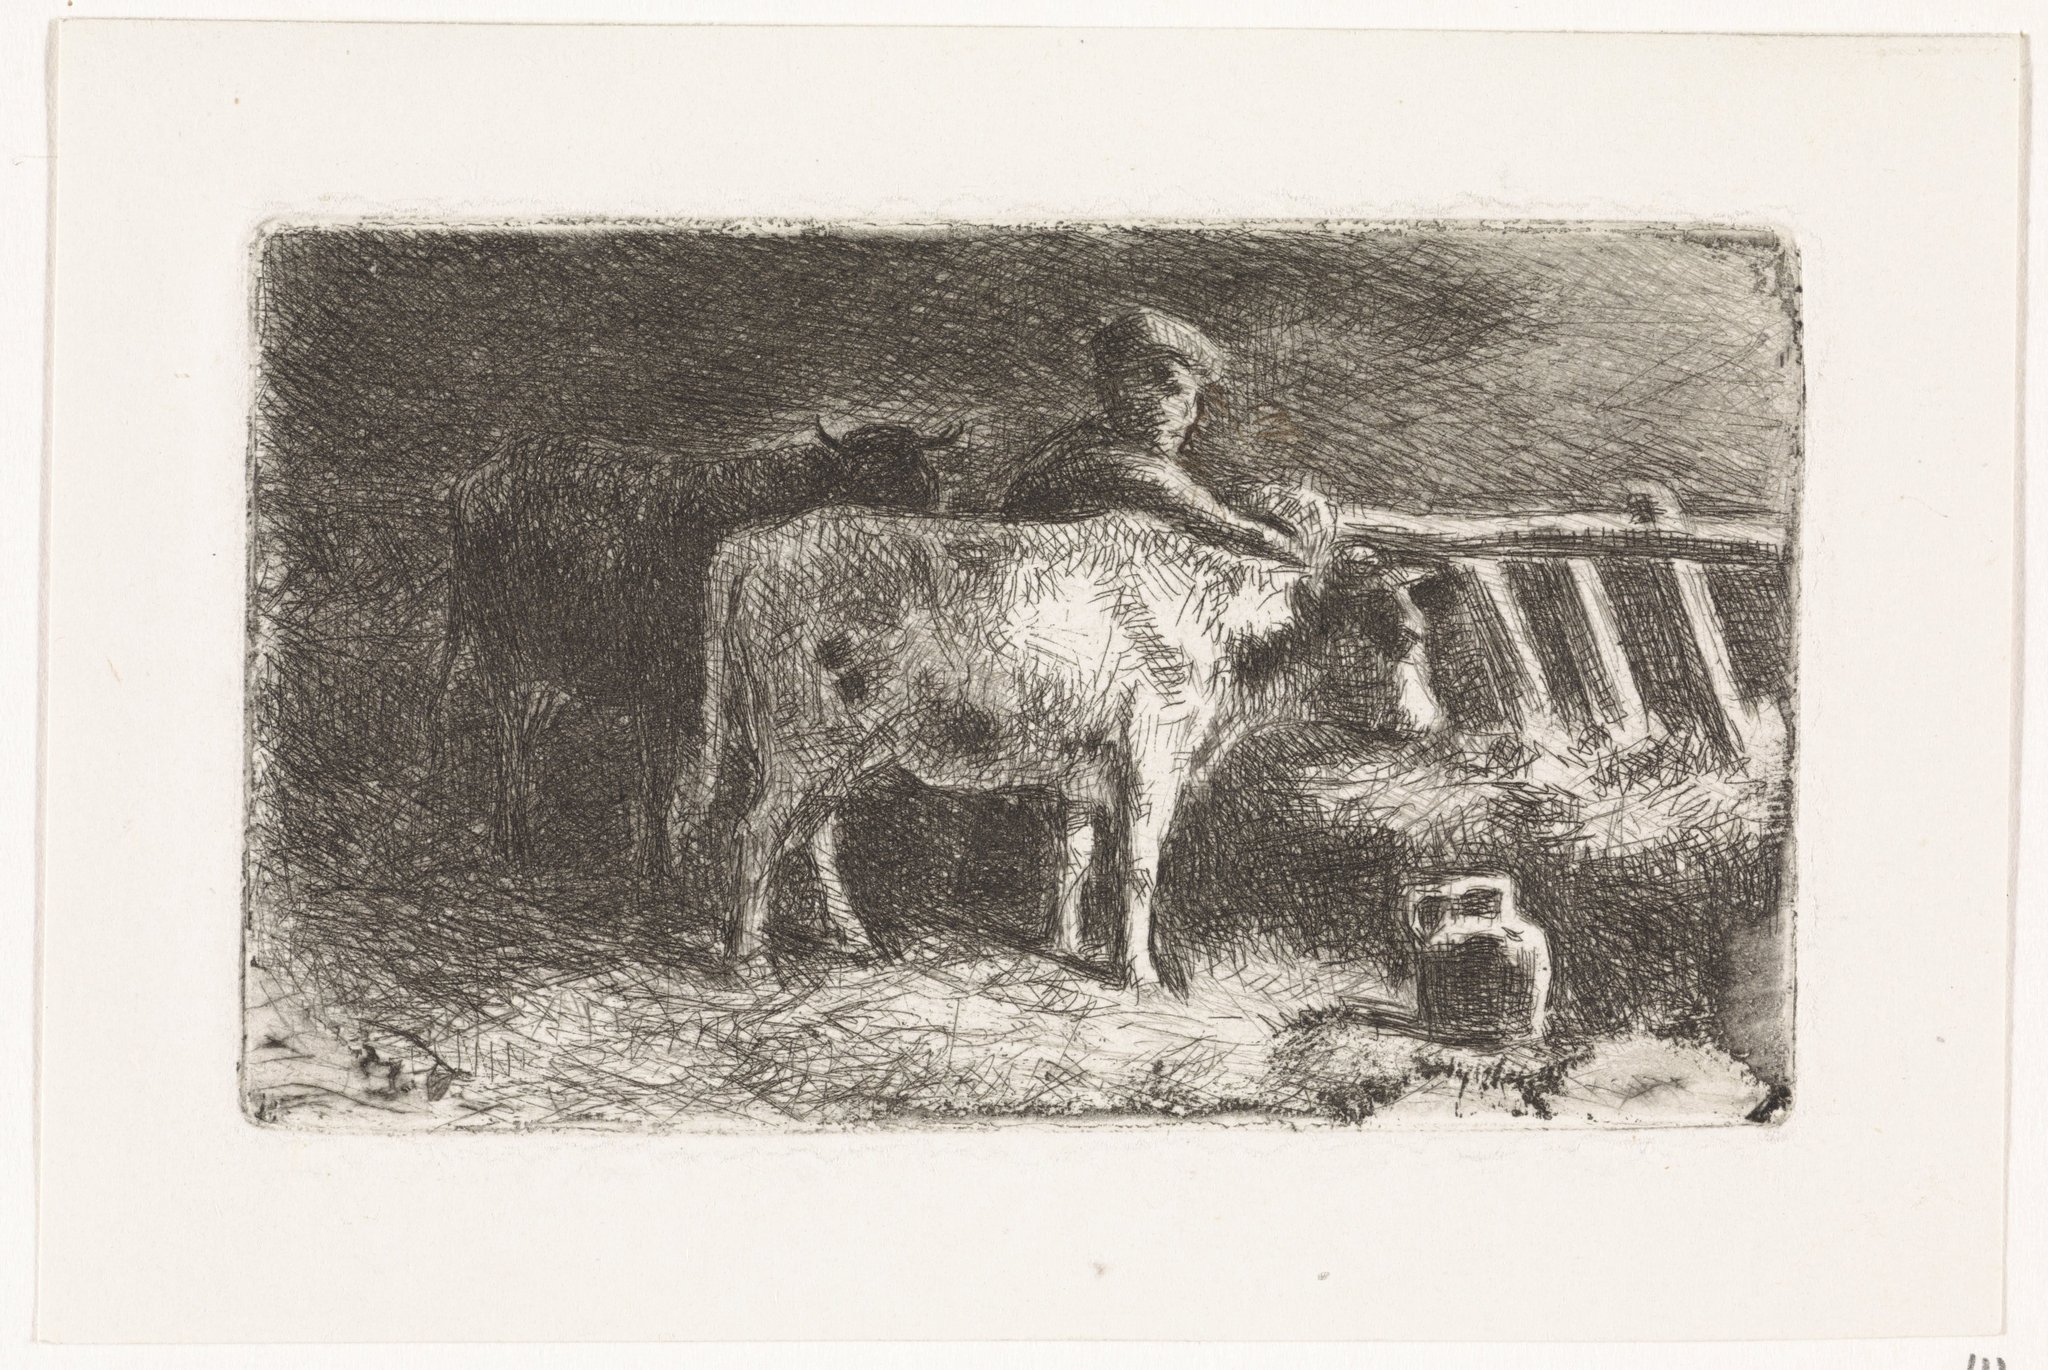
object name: print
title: Boer tussen twee koeien bij een ruif in een stal (kleine variant)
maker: jan vrolijk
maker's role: draughtsman, painter, print maker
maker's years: 1846-1894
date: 1860-1885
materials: paper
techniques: drypoint, etching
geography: the hague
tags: cow, farmers, stall, stable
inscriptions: collector's mark: Lugt 2228